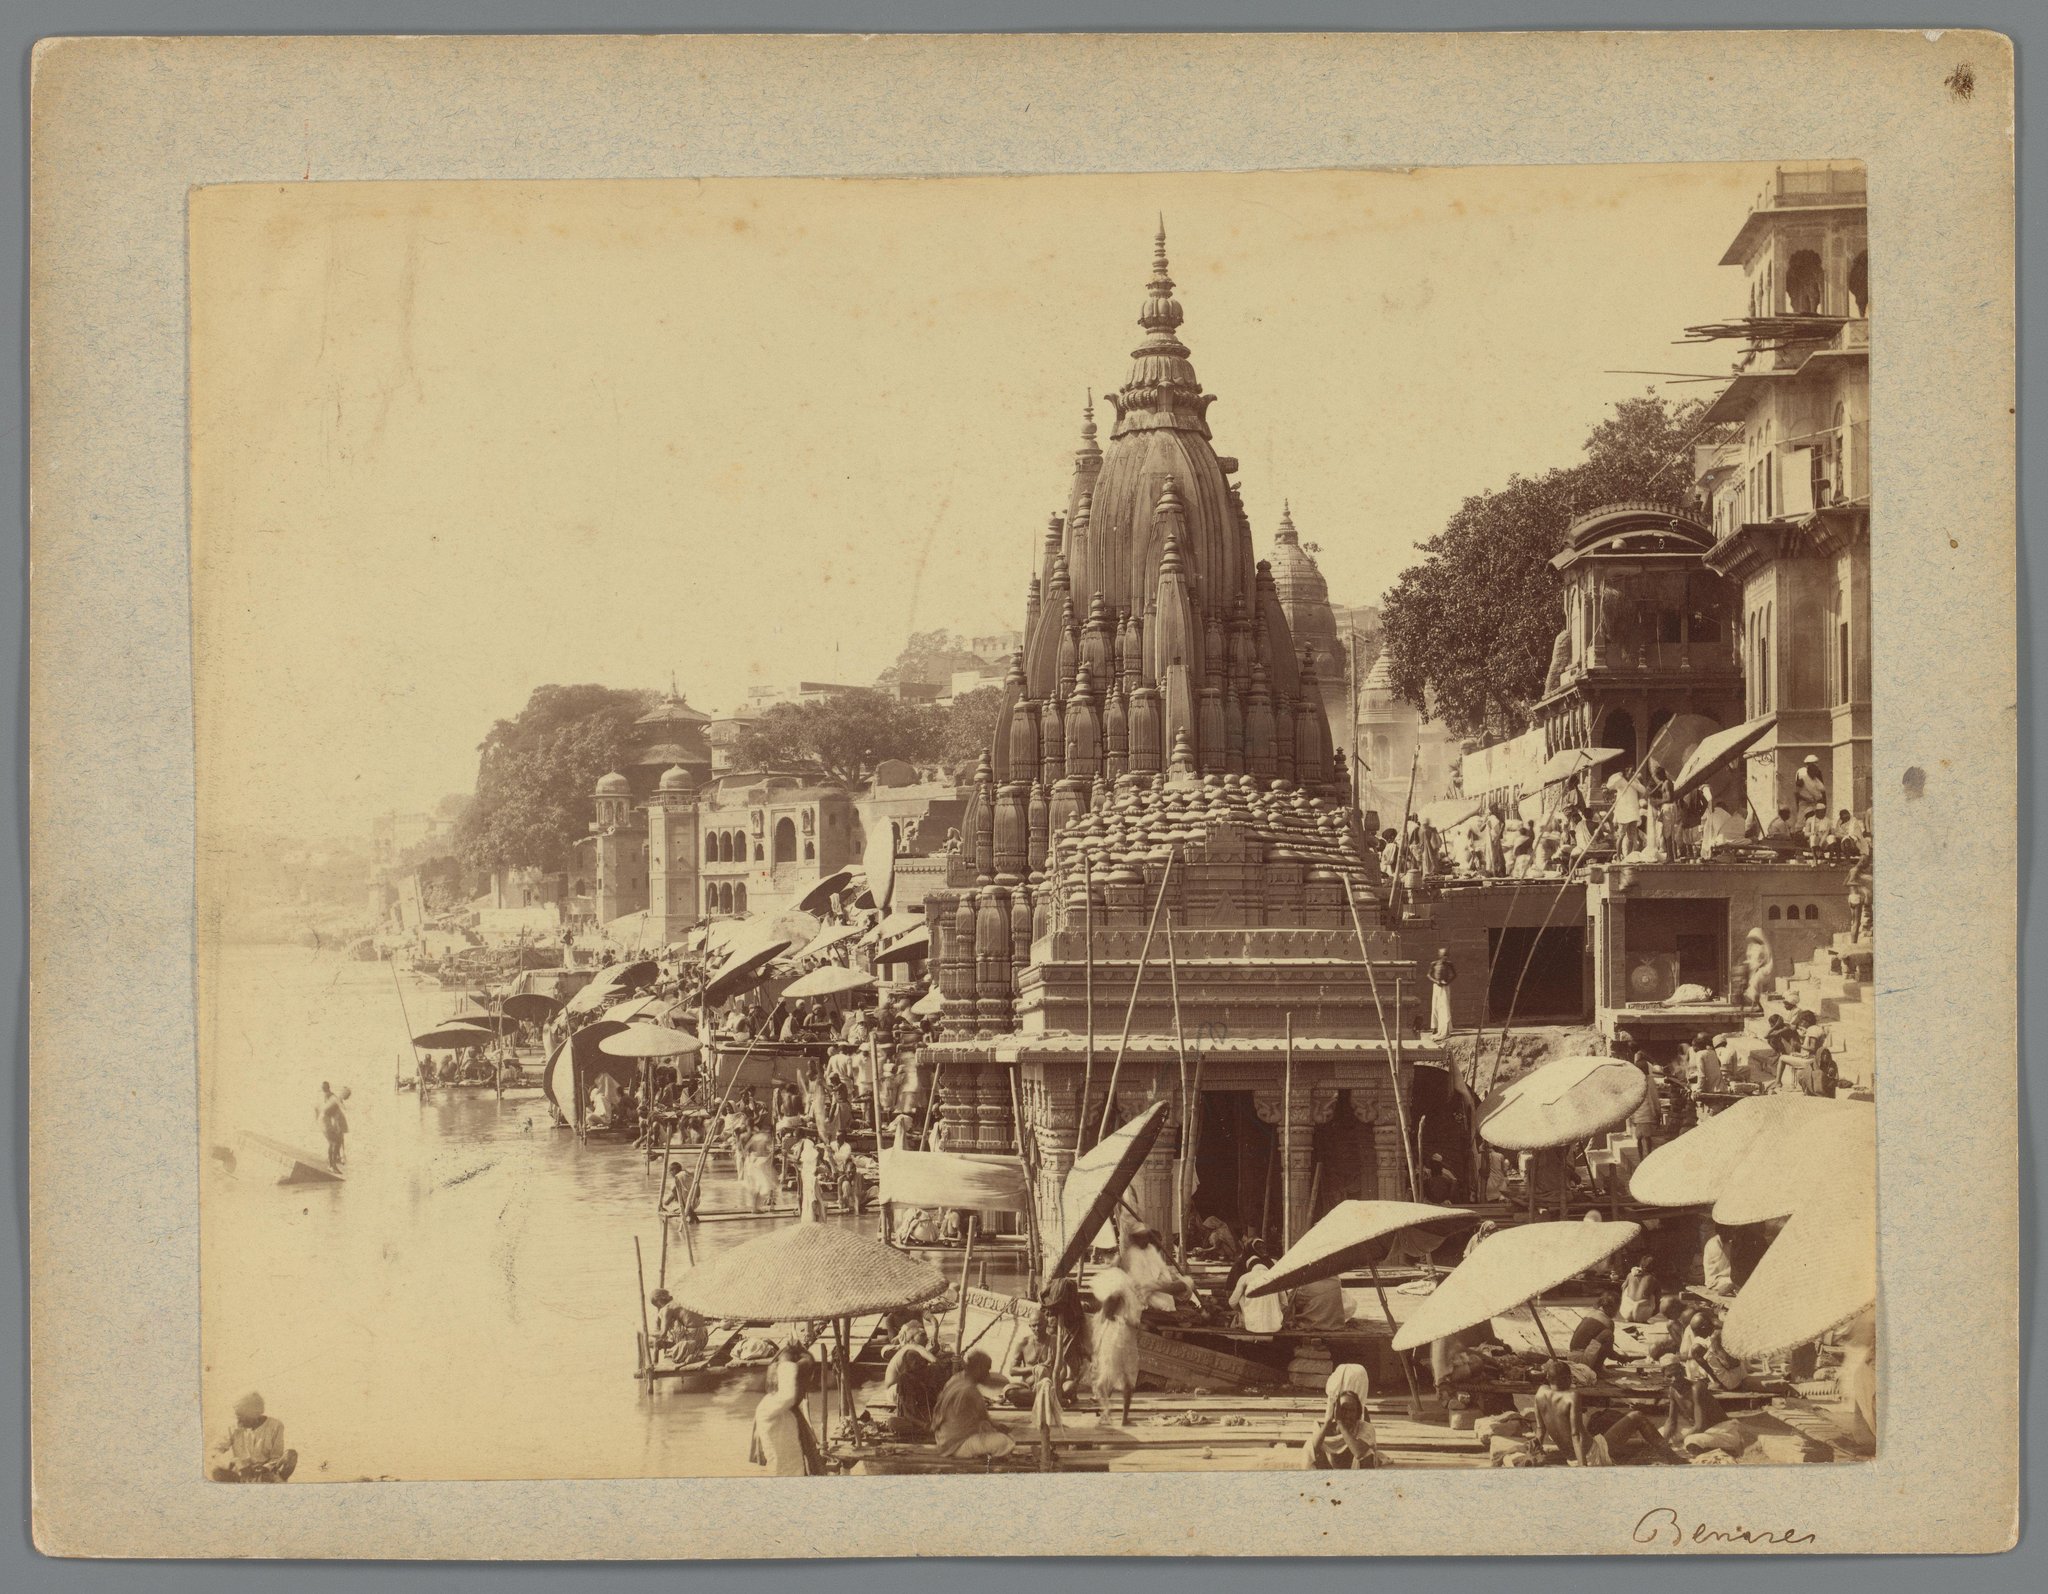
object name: photograph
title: View of temples and buildings on the banks of the Ganga river, Varanasi, Uttar Pradesh, India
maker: Anonymous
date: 1870-1890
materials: cardboard, photographic support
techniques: albumen print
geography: varanasi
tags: places and objects of worship ~ hinduism, buddhism, jainism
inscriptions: inscription: ‘Benares’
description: Op de achterzijde is een schets gemaakt van een gebouwencomplex, met plattegronden.